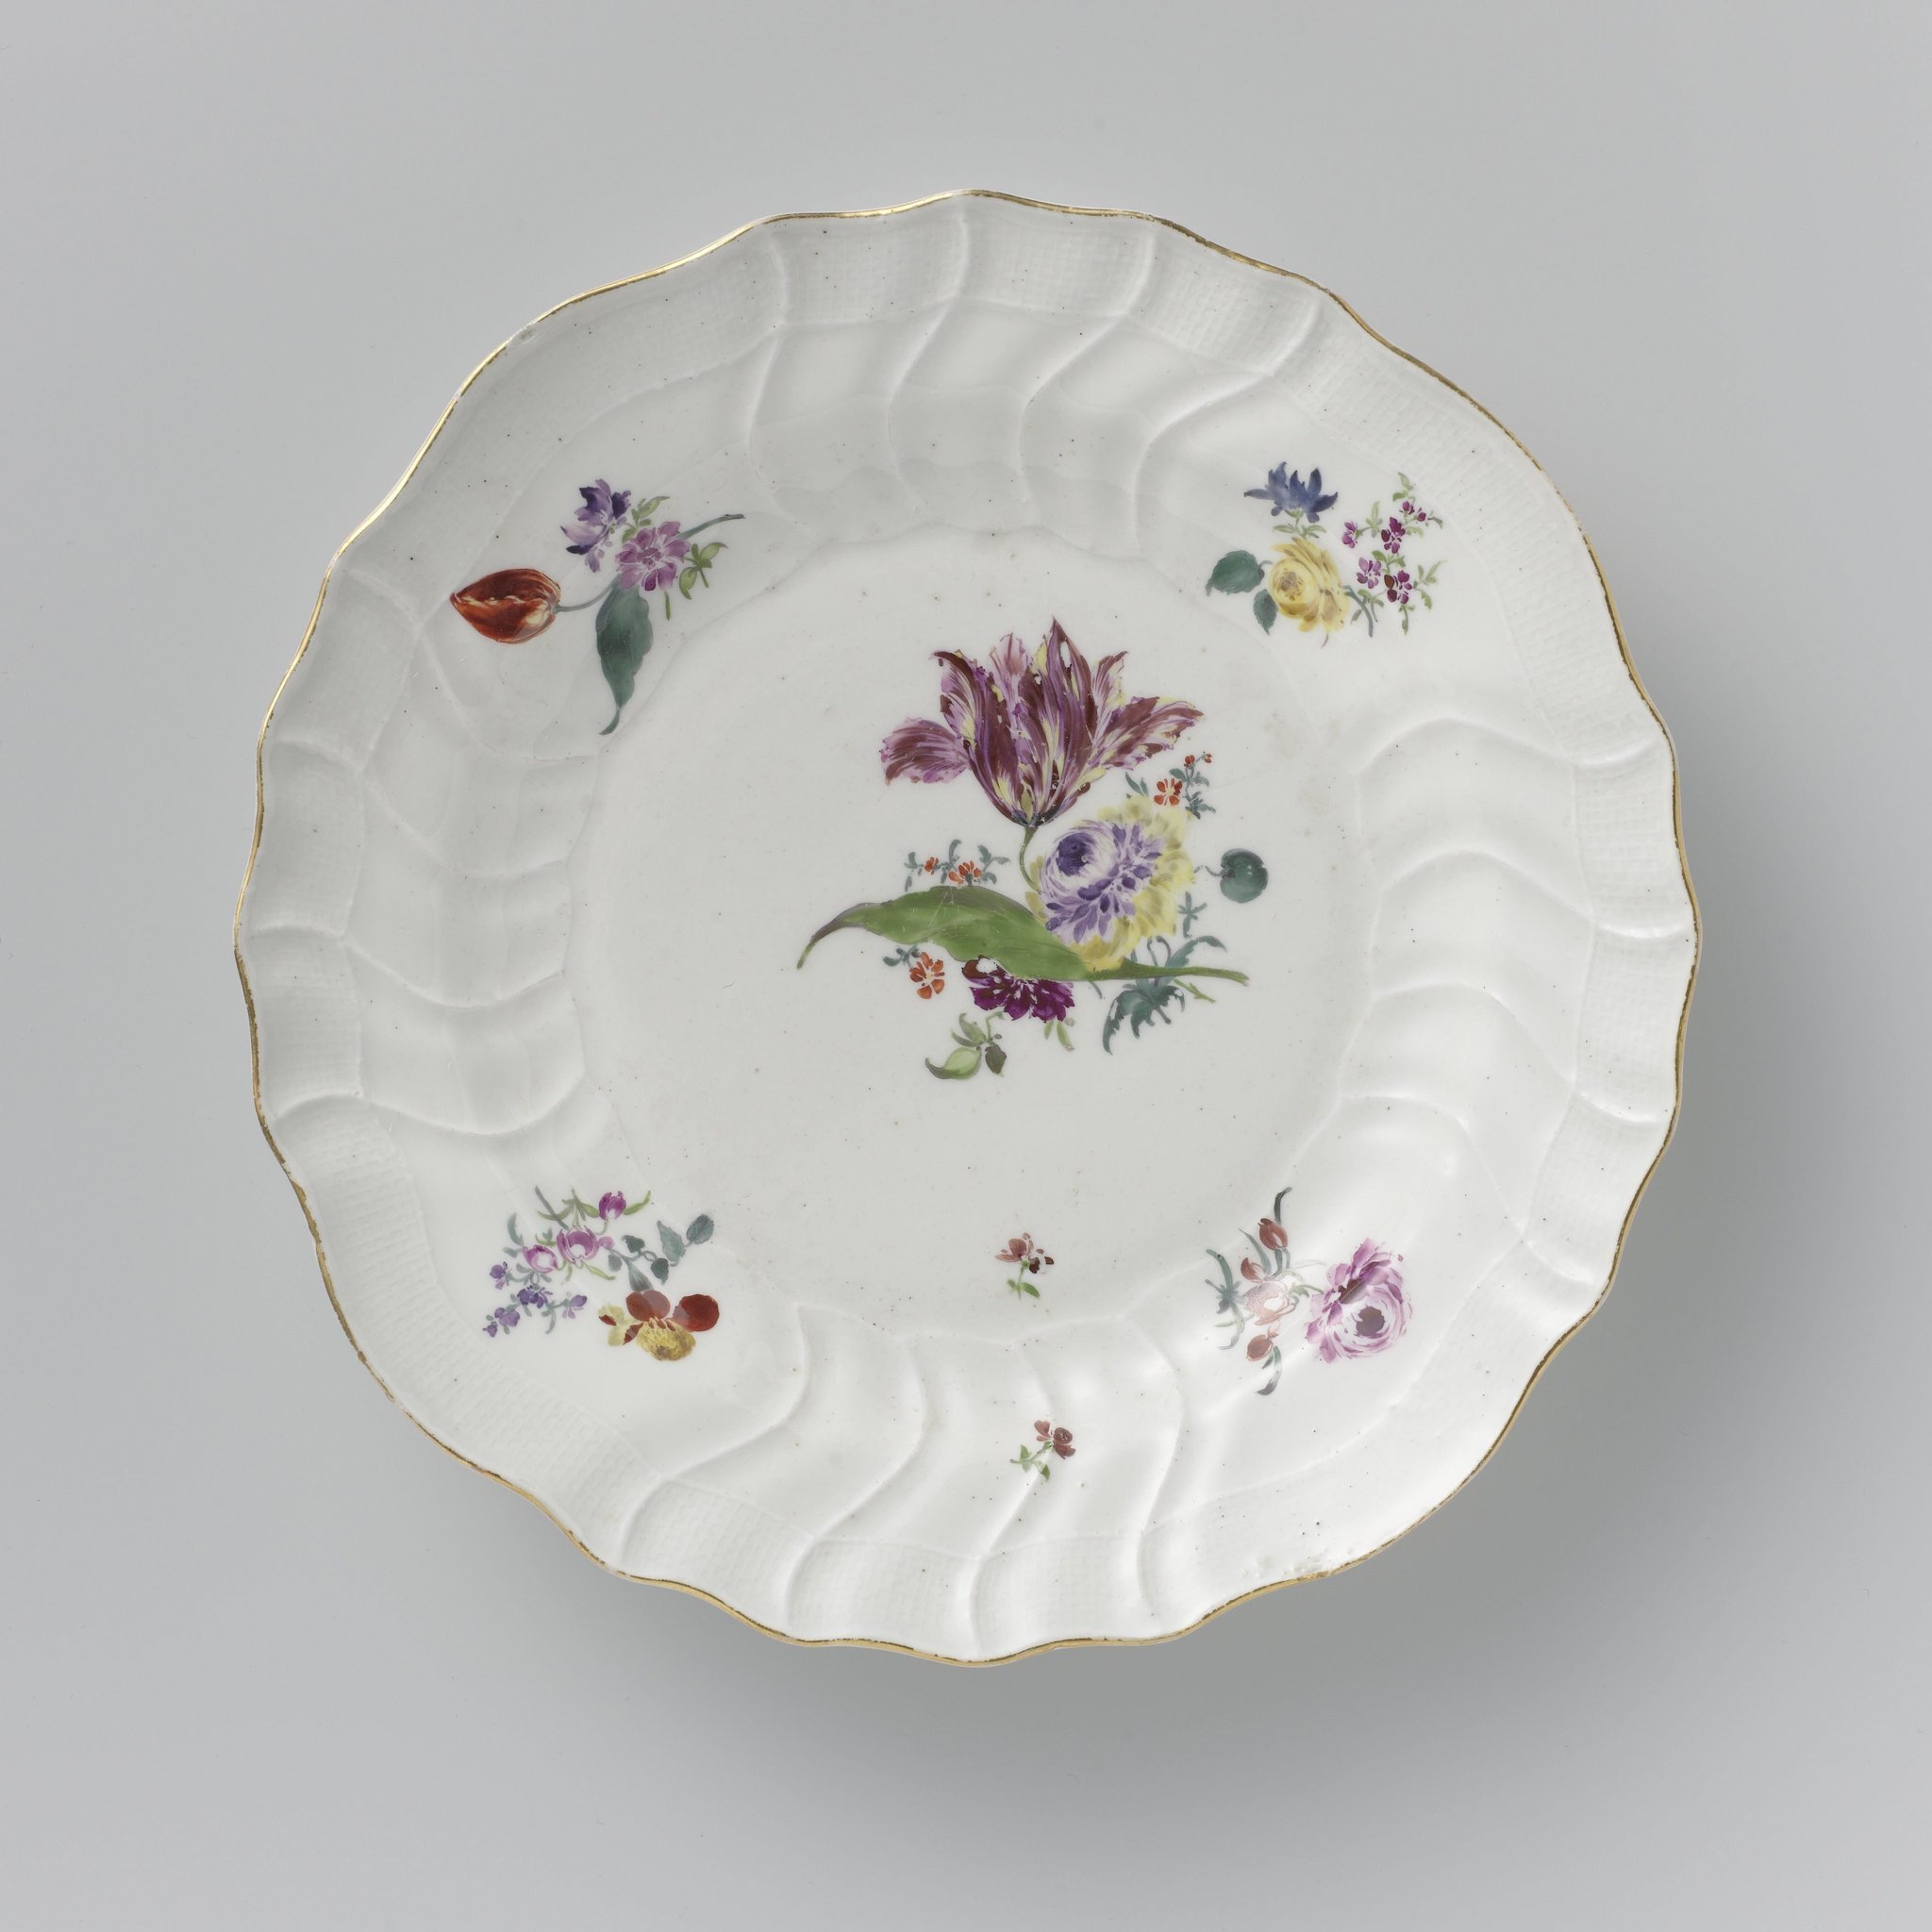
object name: eating drinking utensil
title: Bord, veelkleurig beschilderd met Deutsche Blumen, insekten en vruchten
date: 1750-1760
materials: porcelain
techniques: painted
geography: meissen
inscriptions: factory mark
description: Rond bord van beschilderd porselein. Het bord is beschilderd met Deutsche Blumen, insekten en vruchten. De rand is in reliëf versierd met het Neuozier-patroon. Het bord is gemerkt en hoort bij een servies (BK-17474-1 t/m BK-17474-253).